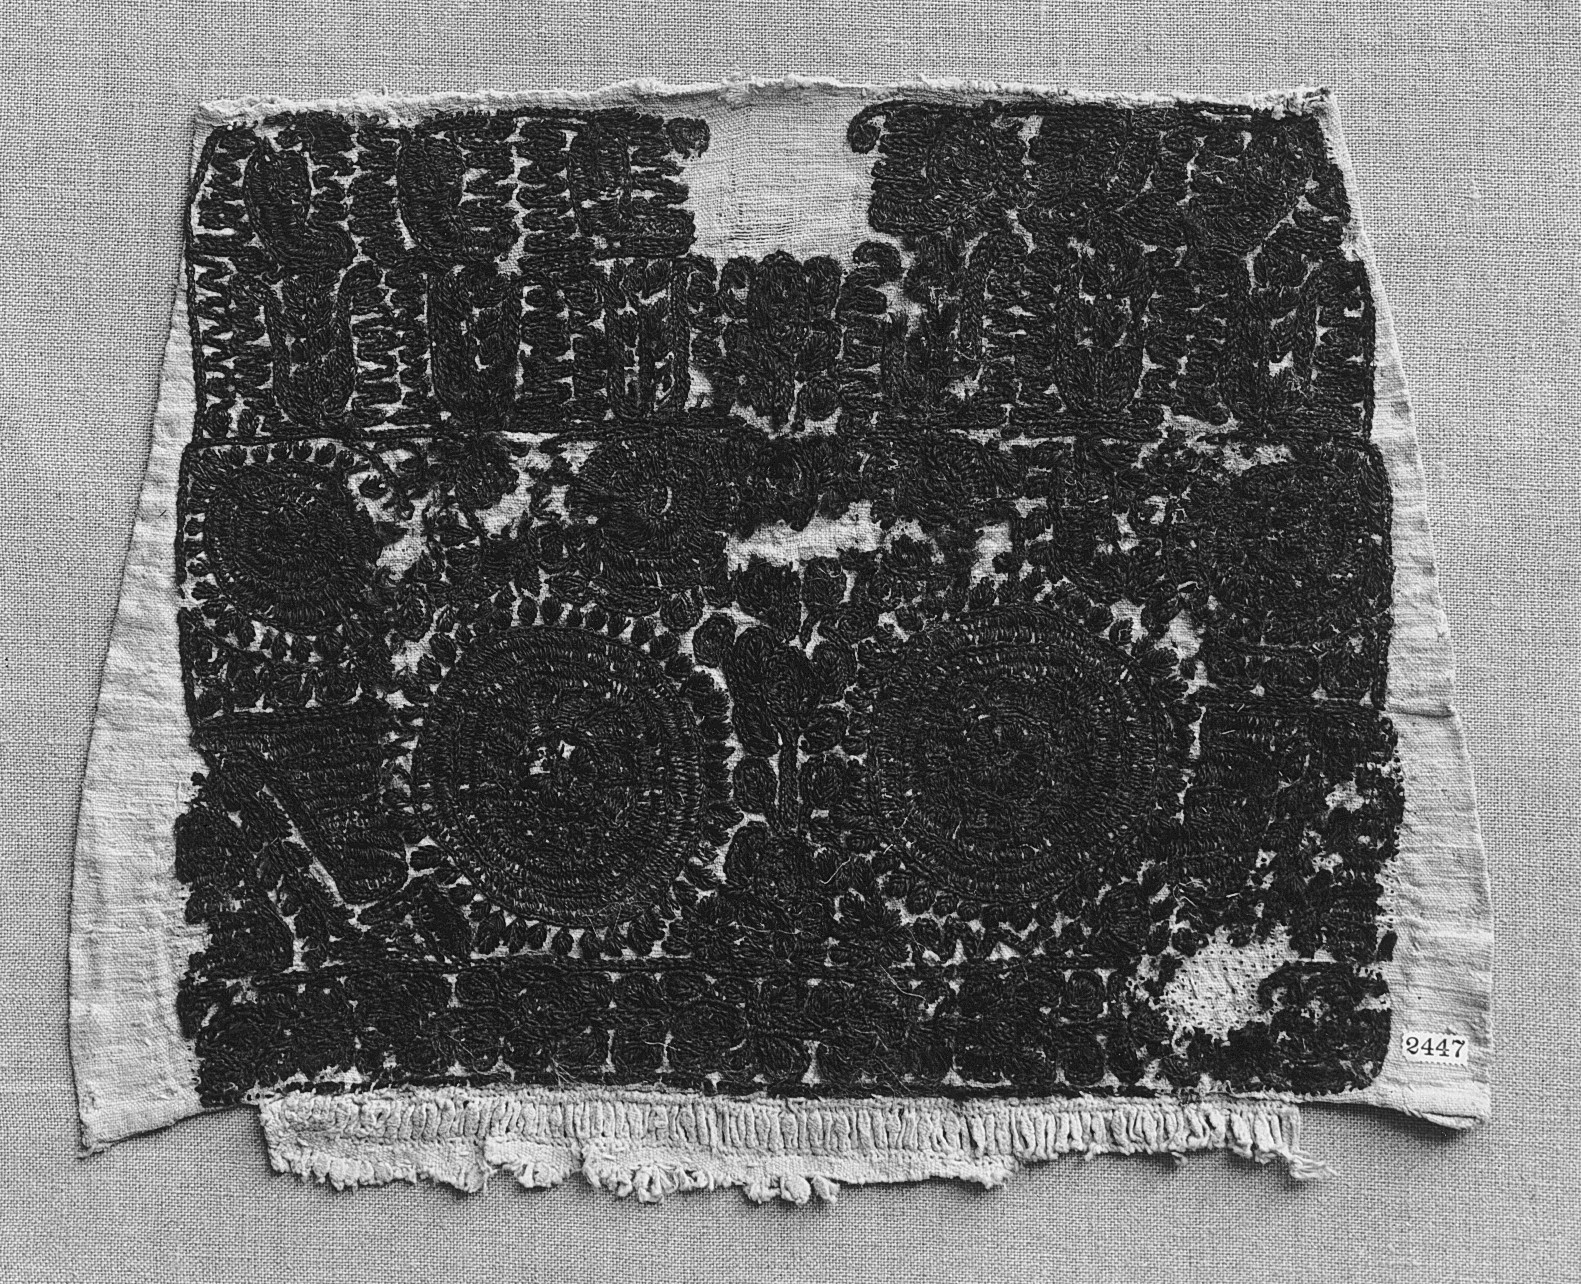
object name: sleeve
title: Sleeve (?)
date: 1801-1833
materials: linen, wool